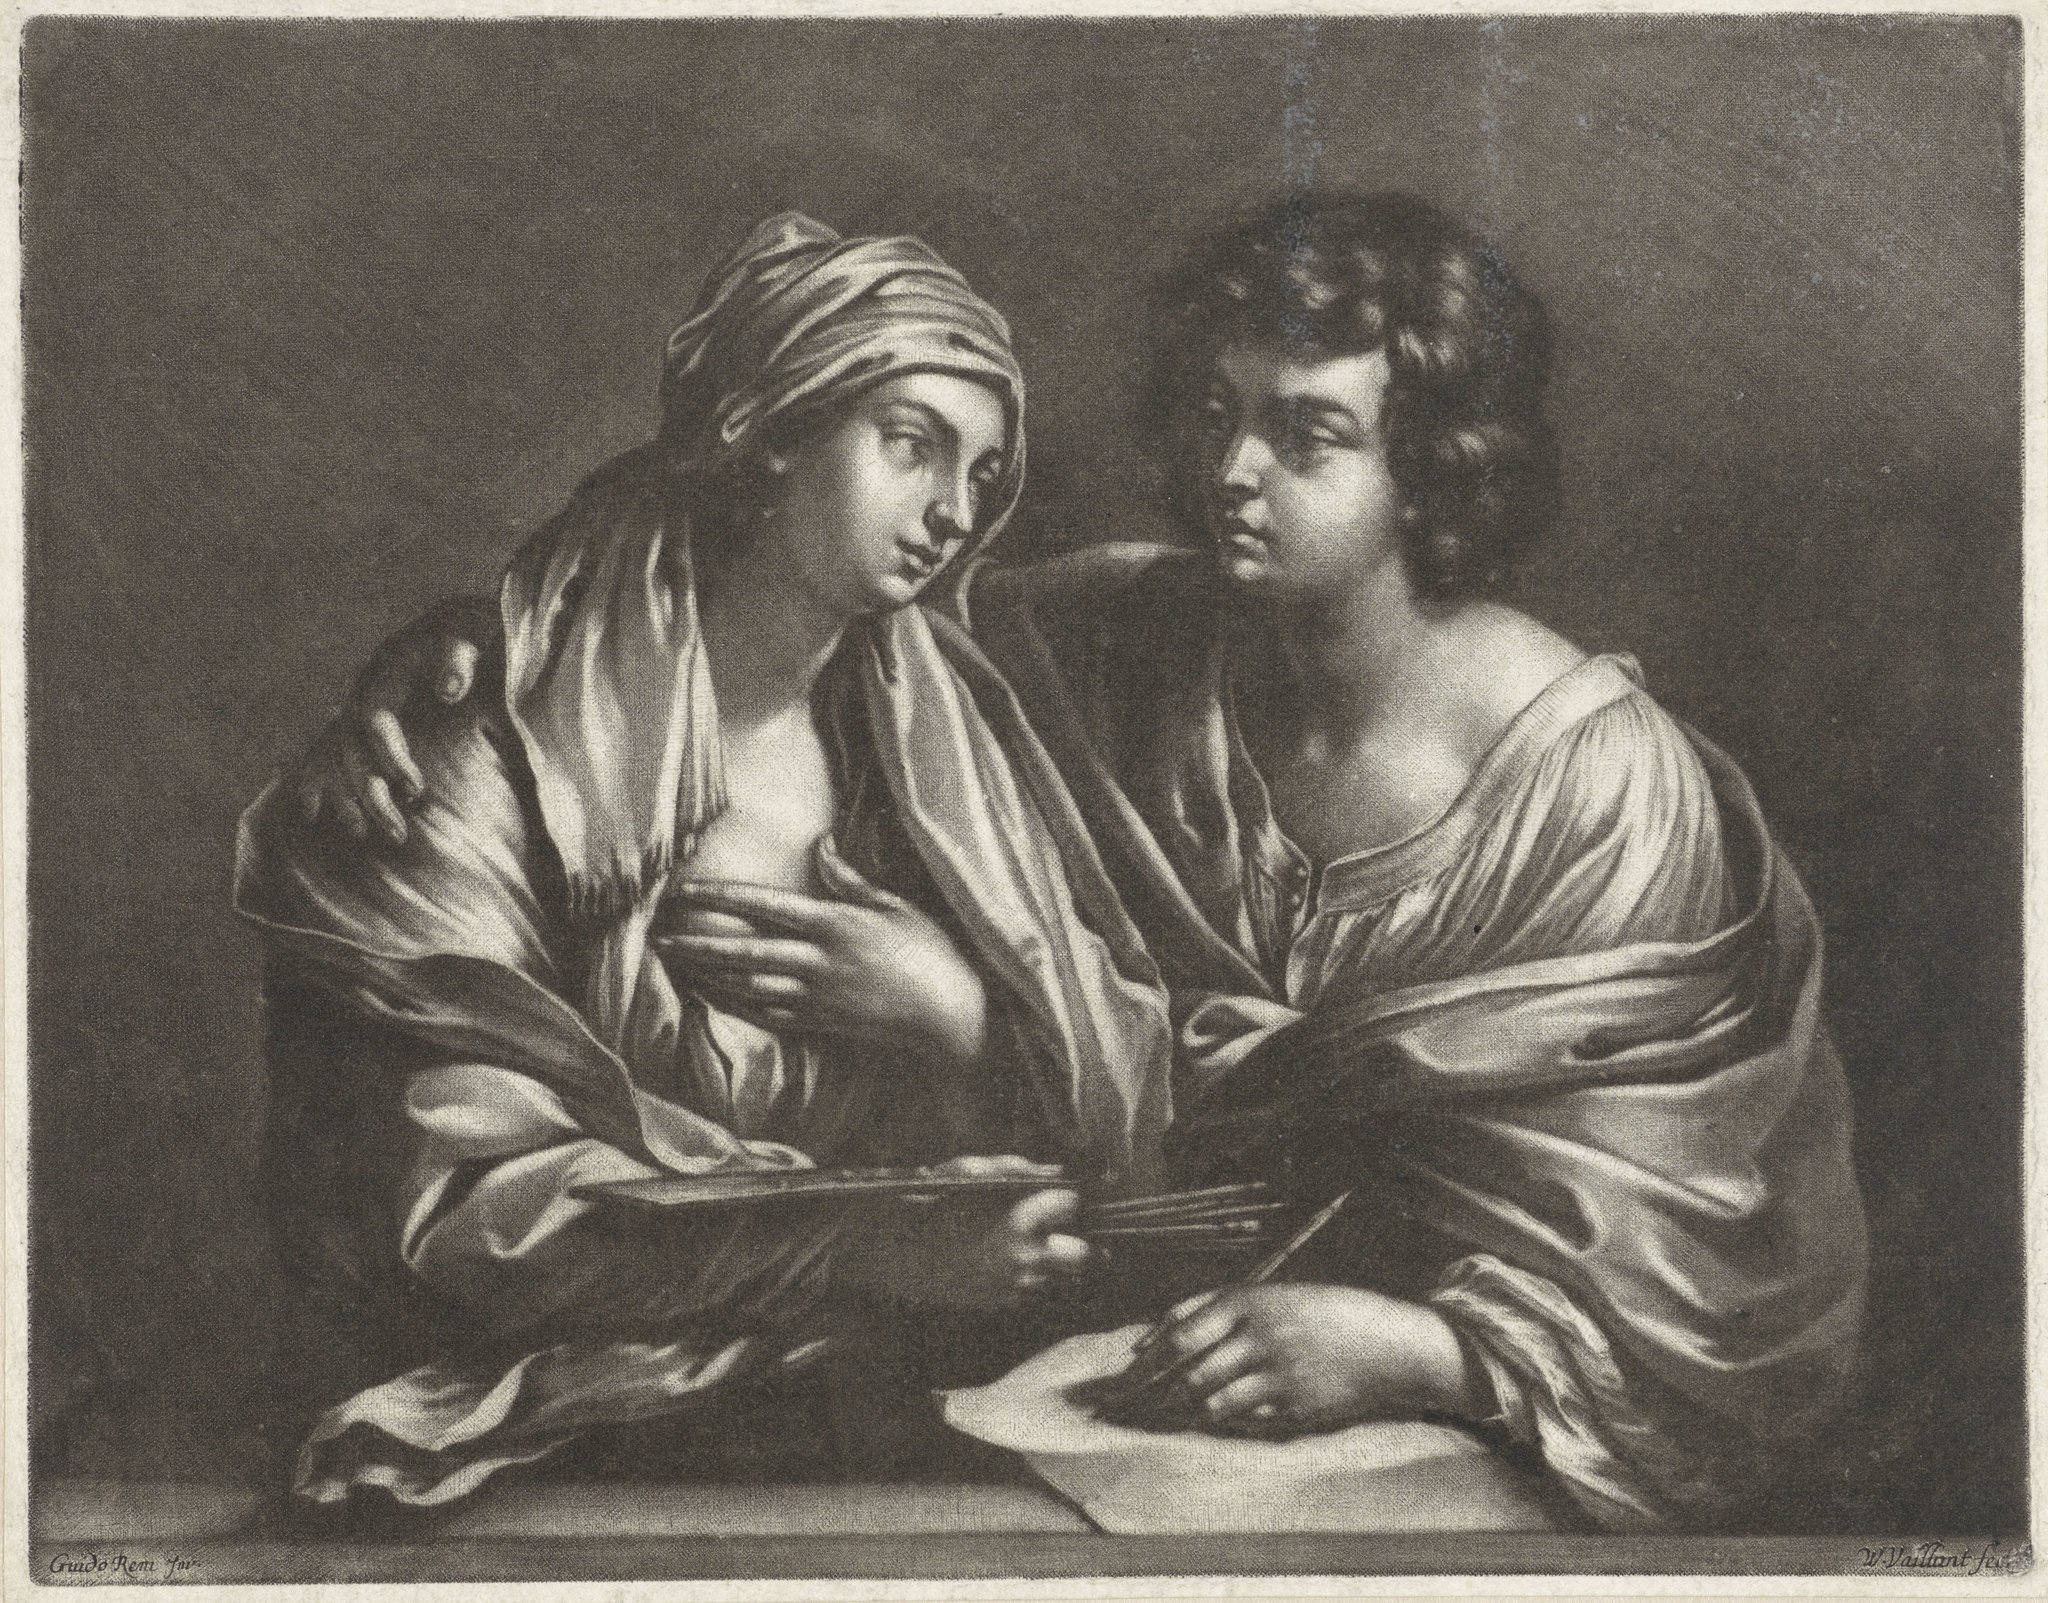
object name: print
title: Schilderkunst en tekenkunst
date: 1658-1677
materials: paper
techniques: mezzotint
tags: 'pictura', symbolic representations, allegories and emblems ~ painting; 'pittura' (ripa), tools, implements of draughtsman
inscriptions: collector's mark: Lugt 2228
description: De schilderkunst en de tekenkunst gepersonifieerd door een vrouw met schilderspalet en penselen en een jongeman met tekenstift en papier.